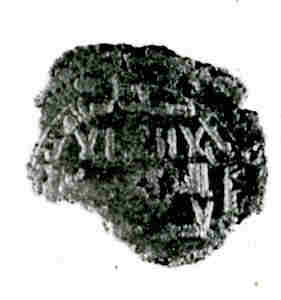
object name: coin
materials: copper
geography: iran